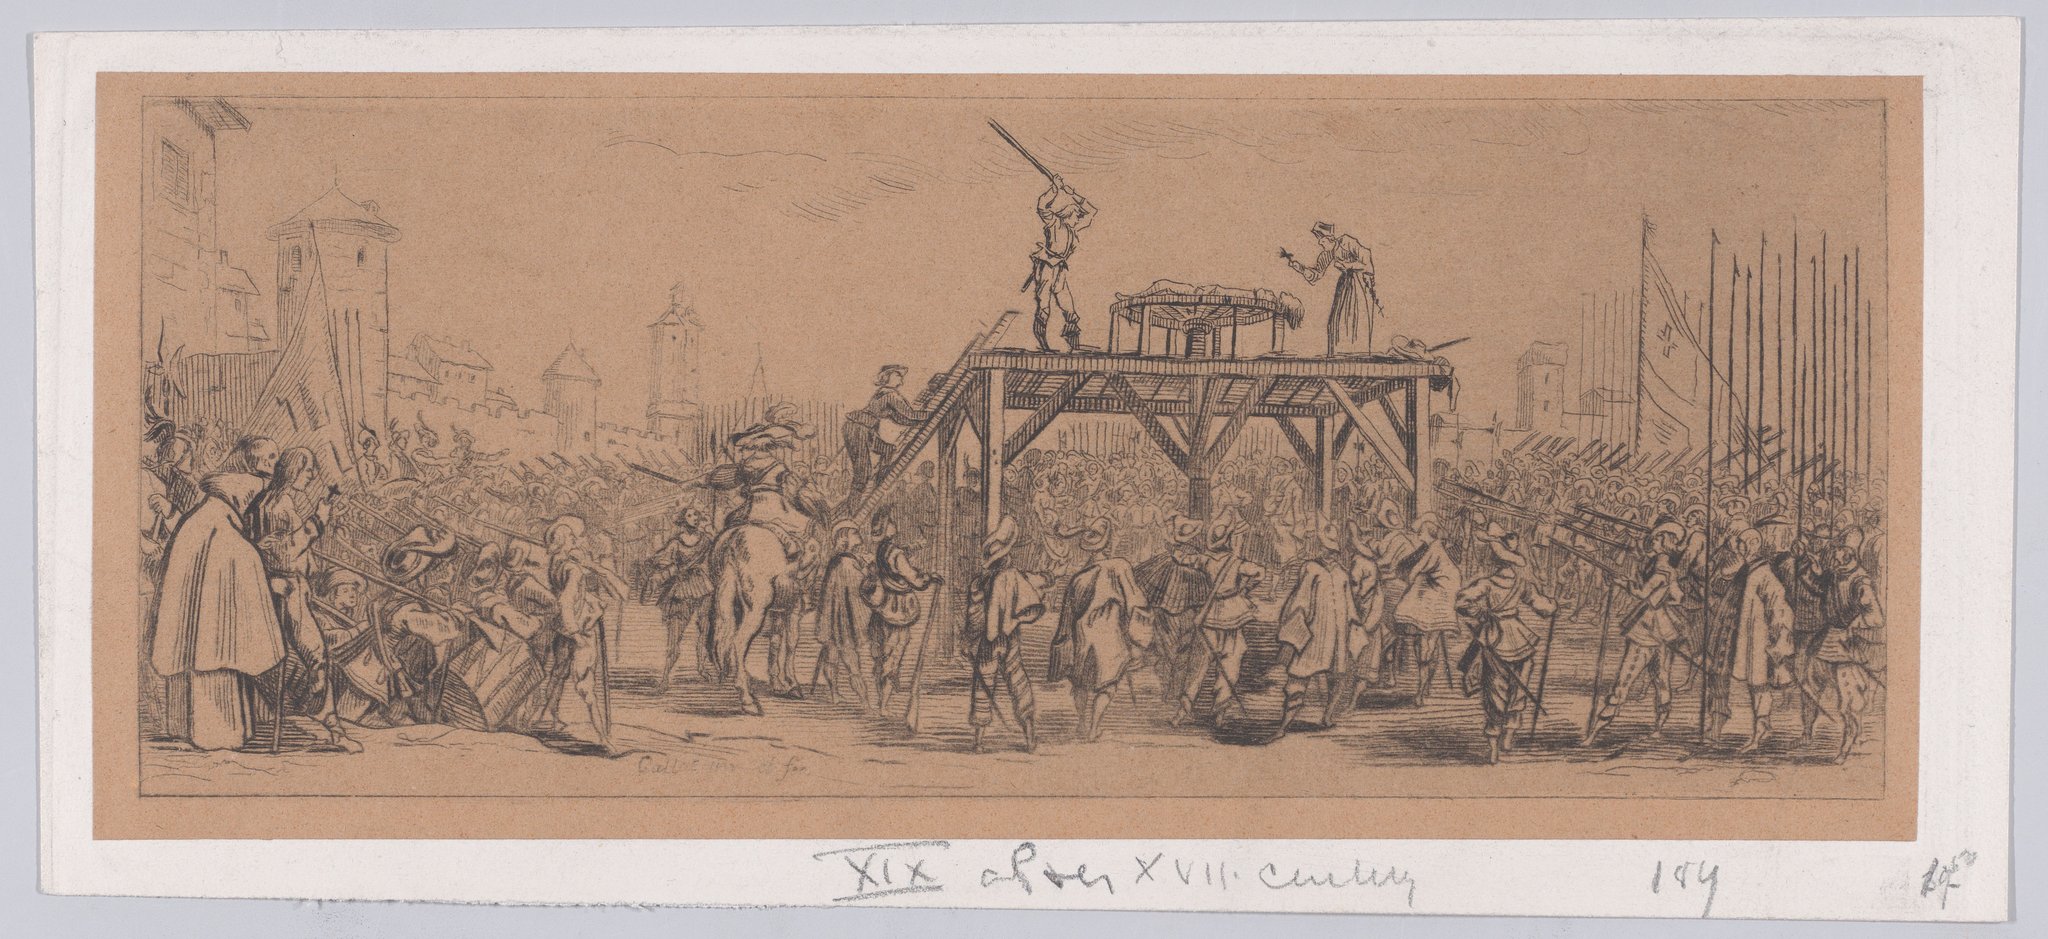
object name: print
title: Copy of La Roue (The Wheel), plate 14 from "Les Misères et les Mal-Heures de la Guerre" (The Miseries and Misfortunes of War)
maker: Anonymous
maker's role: artist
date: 1801-1900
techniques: engraving